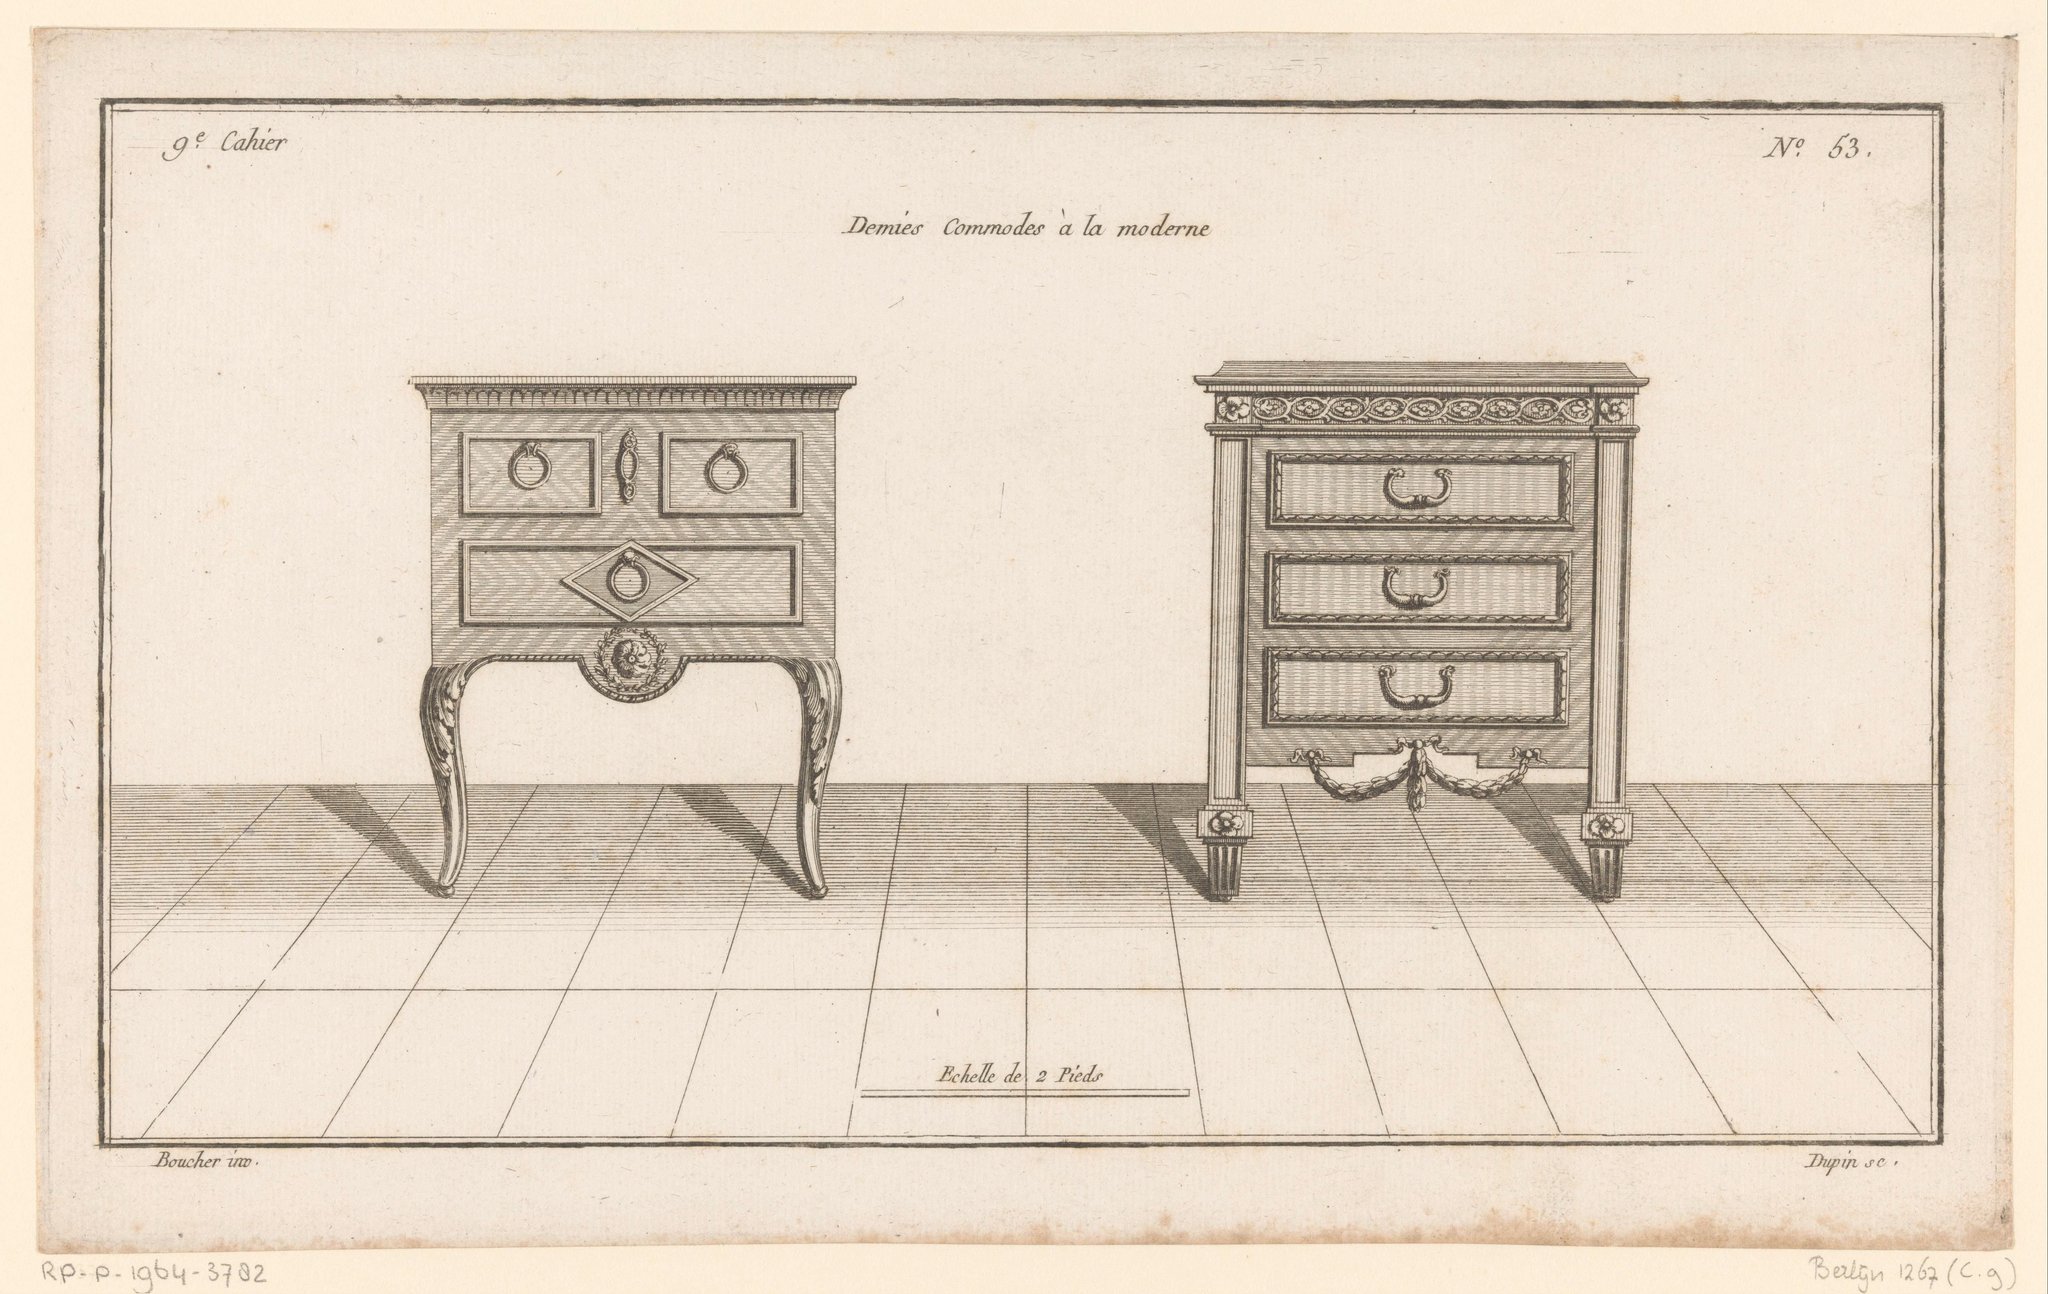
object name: print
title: Demies Commodes à la moderne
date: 1772-1779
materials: paper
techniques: engraving, etching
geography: paris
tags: ornamental cupboard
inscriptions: collector's mark: Lugt 2228, collector's mark: Lugt 2760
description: Twee geornamenteerde commodes met drie lades. Prentnummer 53.